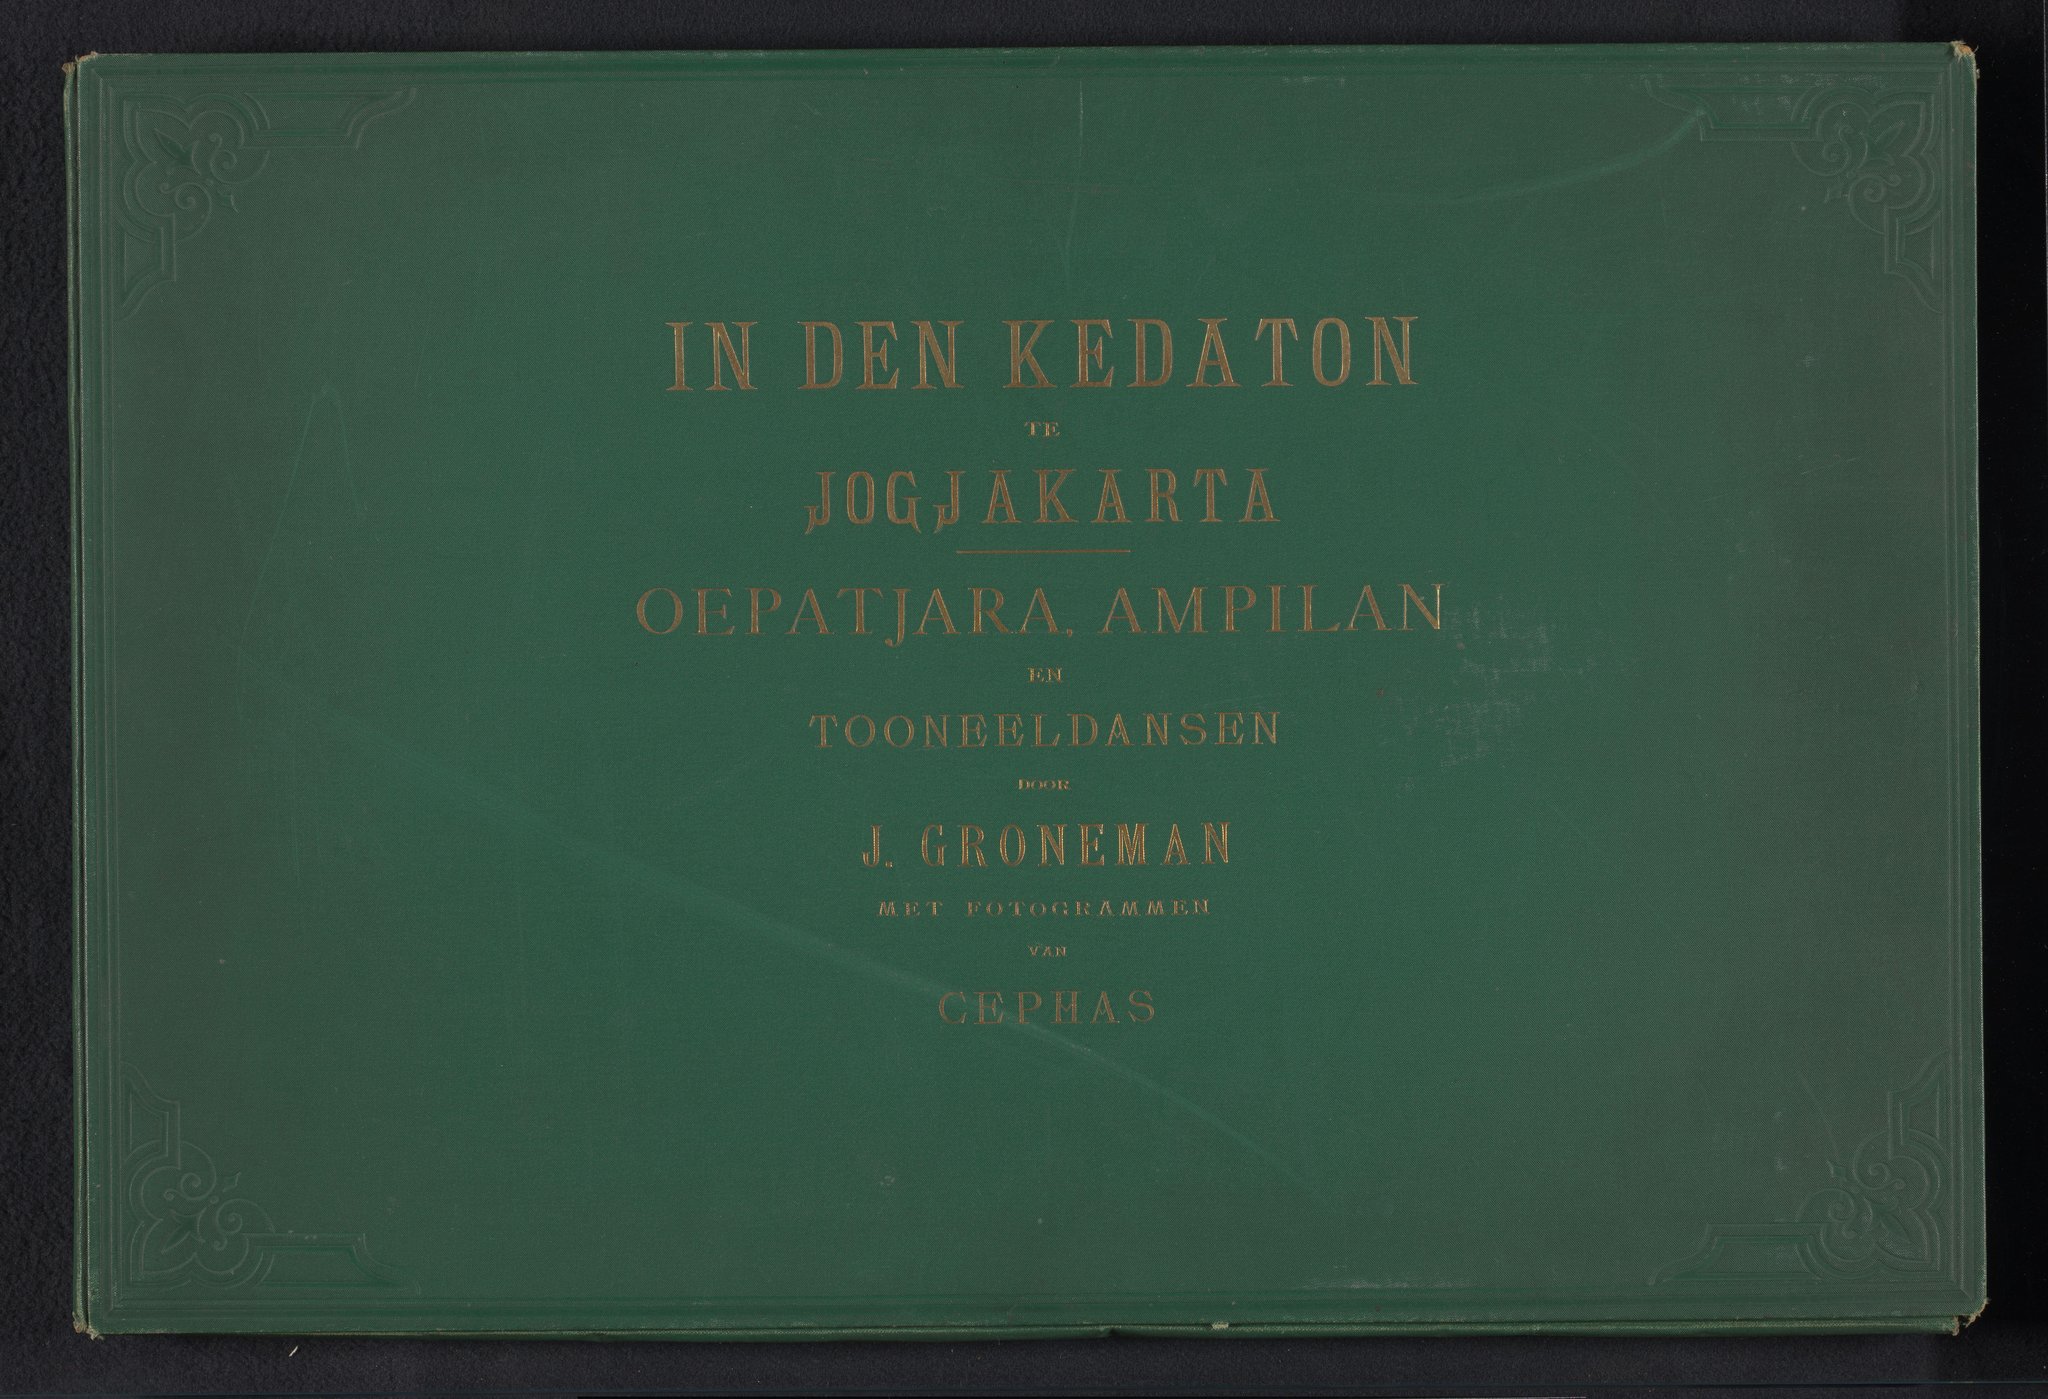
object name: book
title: In den kedaton te Jogjakarta : oepatjara, ampilan en tooneeldansen / door J. Groneman; met fotogrammen van Cephas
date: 1888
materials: cardboard, linen, paper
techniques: photograph, decorated paper, printing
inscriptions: date: ‘OCT/ 1985’